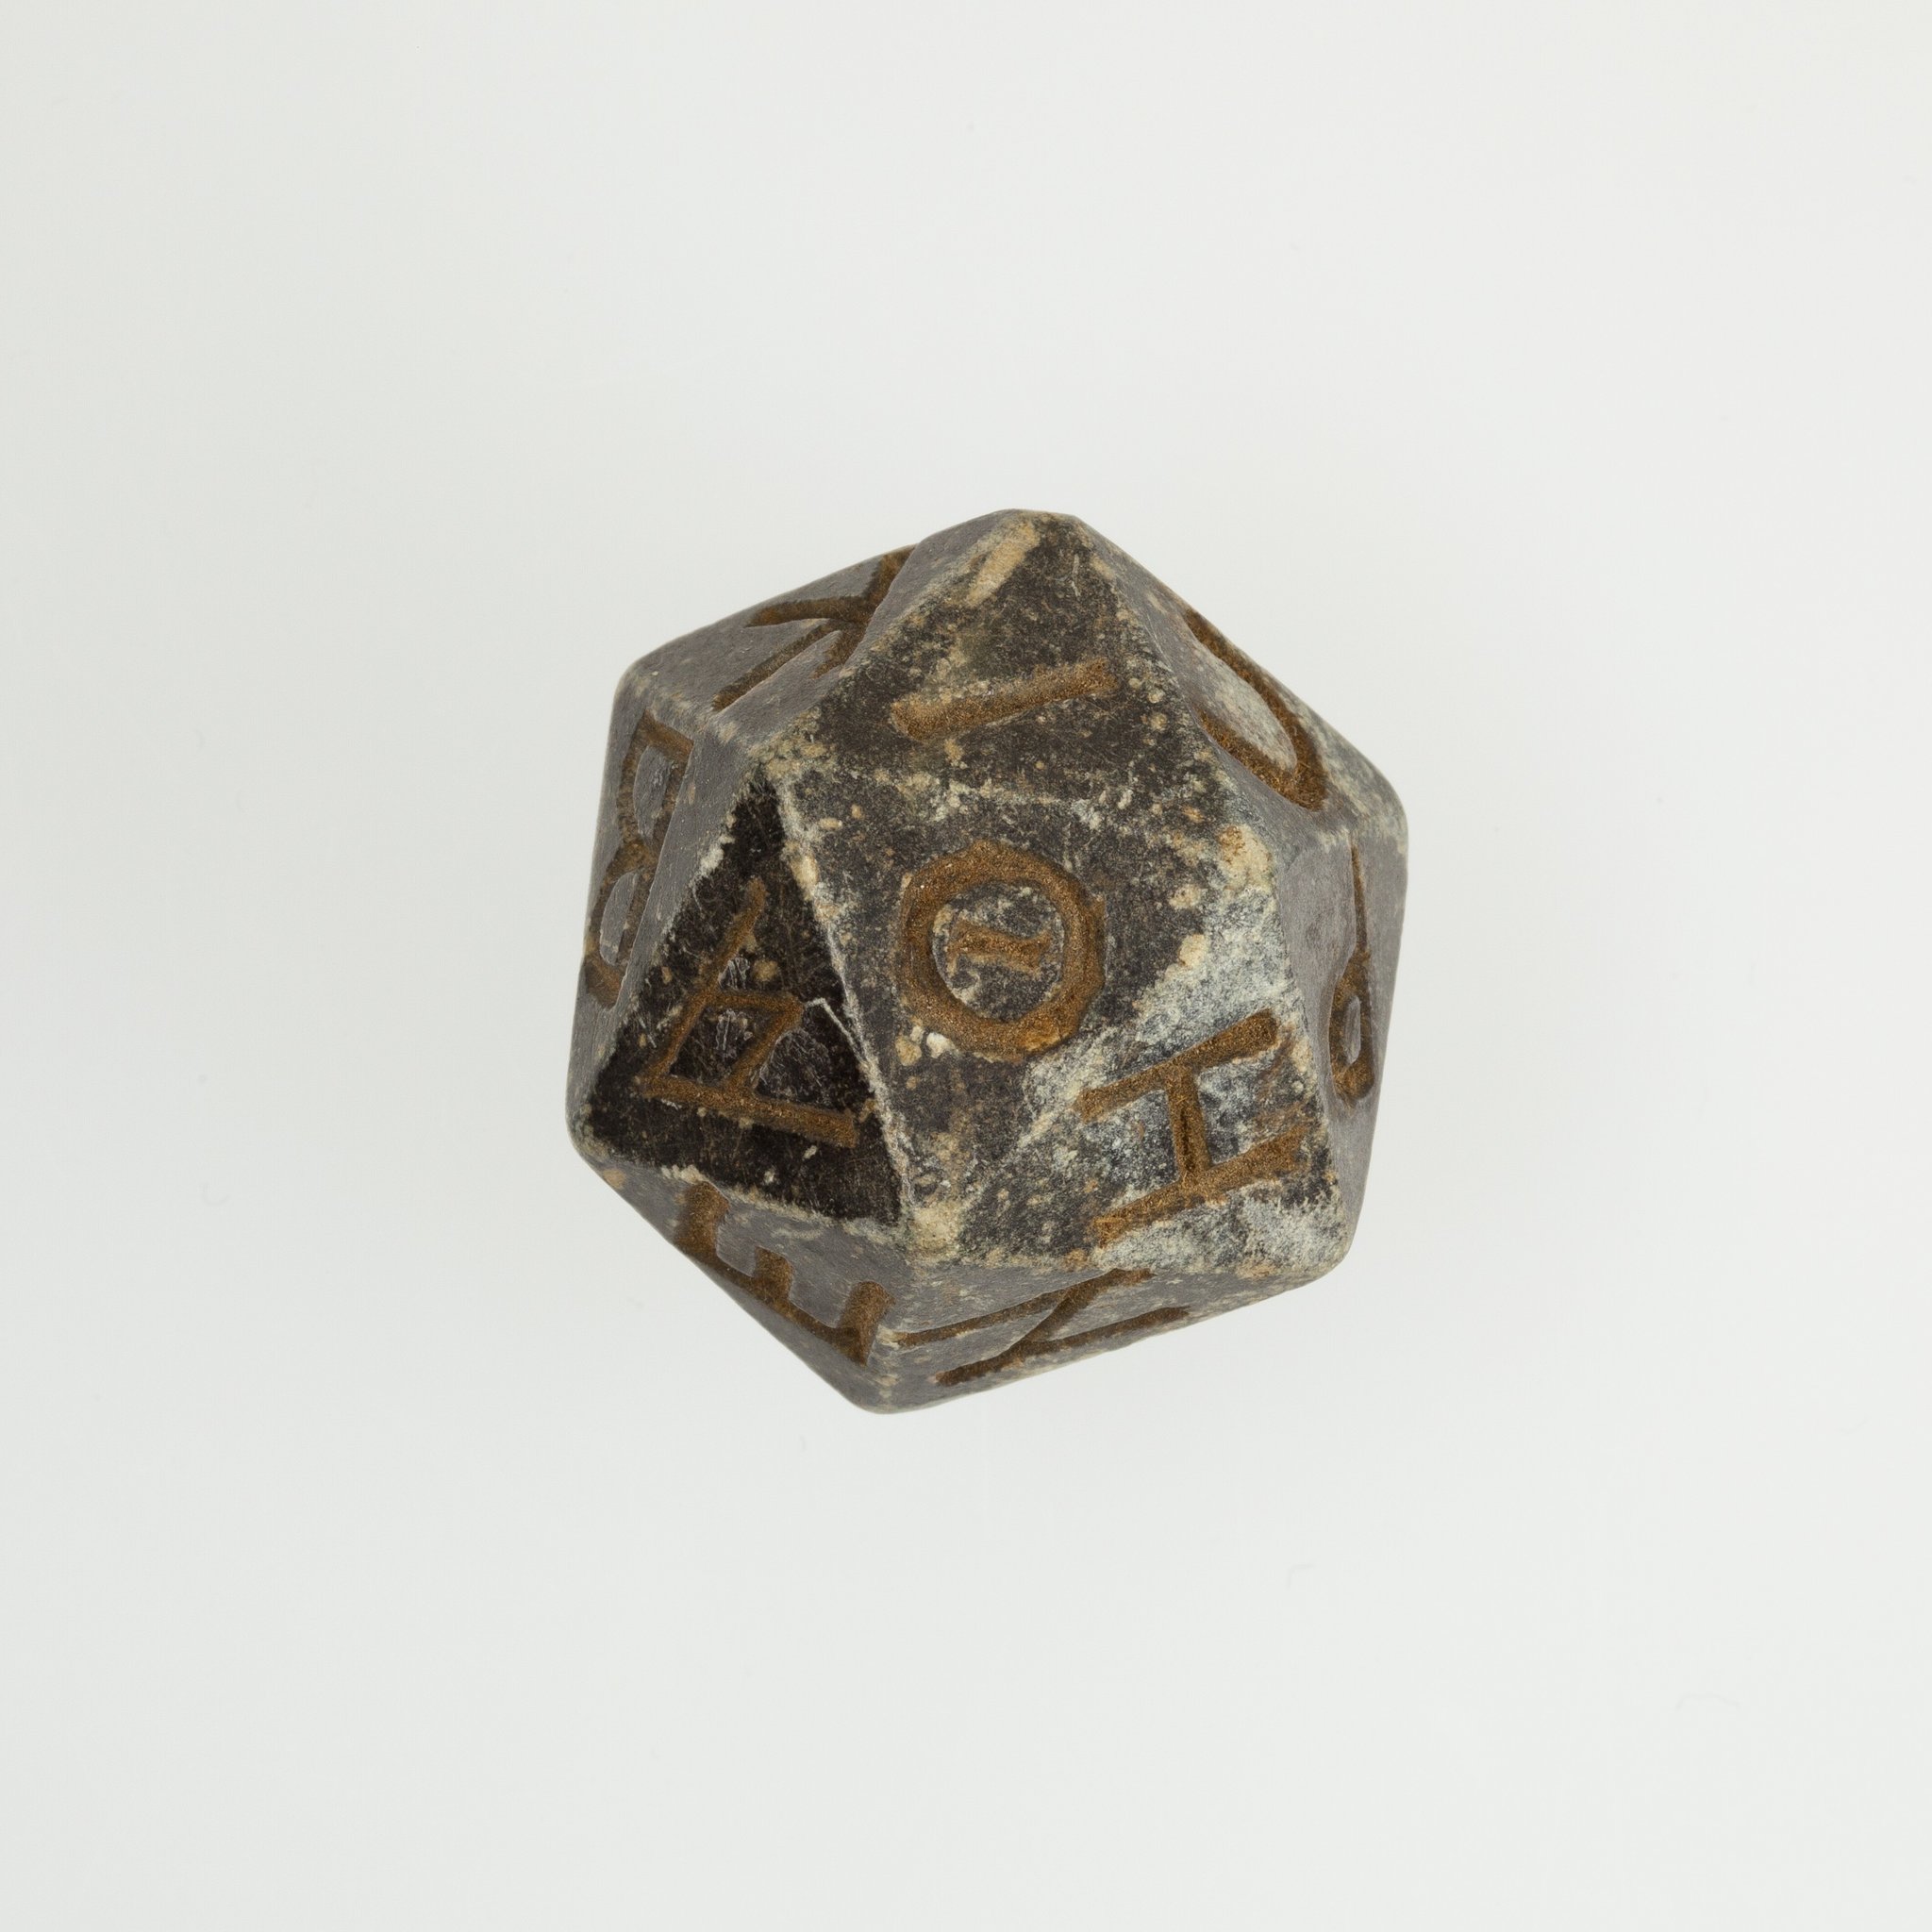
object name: die, icosohedron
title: Twenty-sided die (icosahedron) with faces inscribed with Greek letters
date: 200 BCE-400 CE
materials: stone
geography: egypt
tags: dice,greek